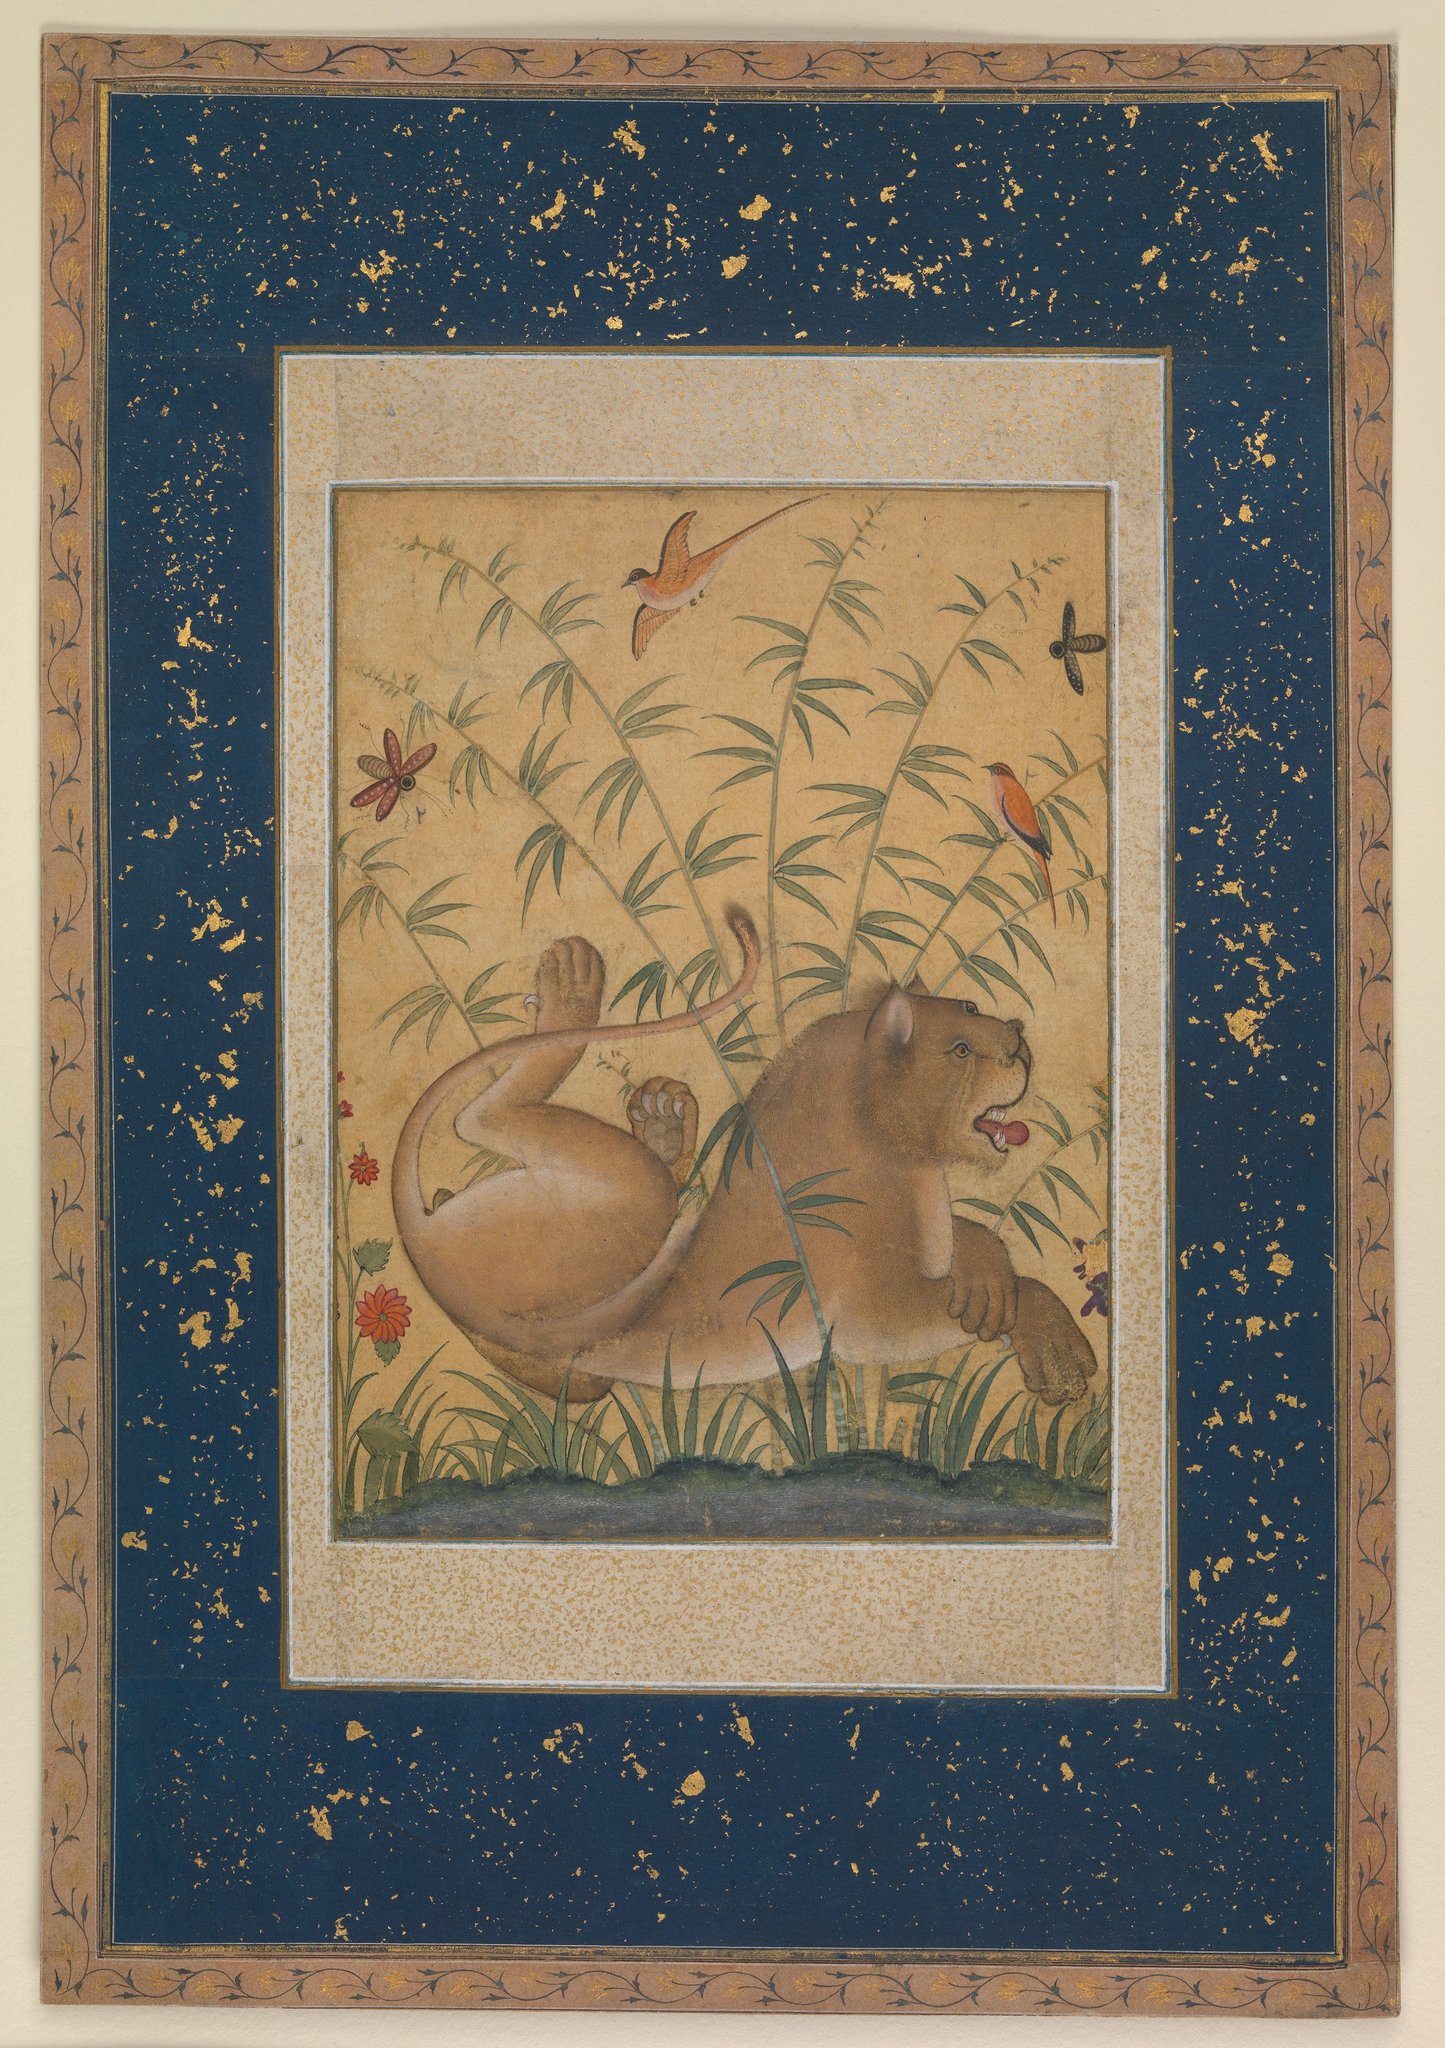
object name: illustrated single work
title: Lion at Rest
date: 1585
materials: gold, ink, paper, silver, watercolor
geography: india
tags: birds,insects,lions